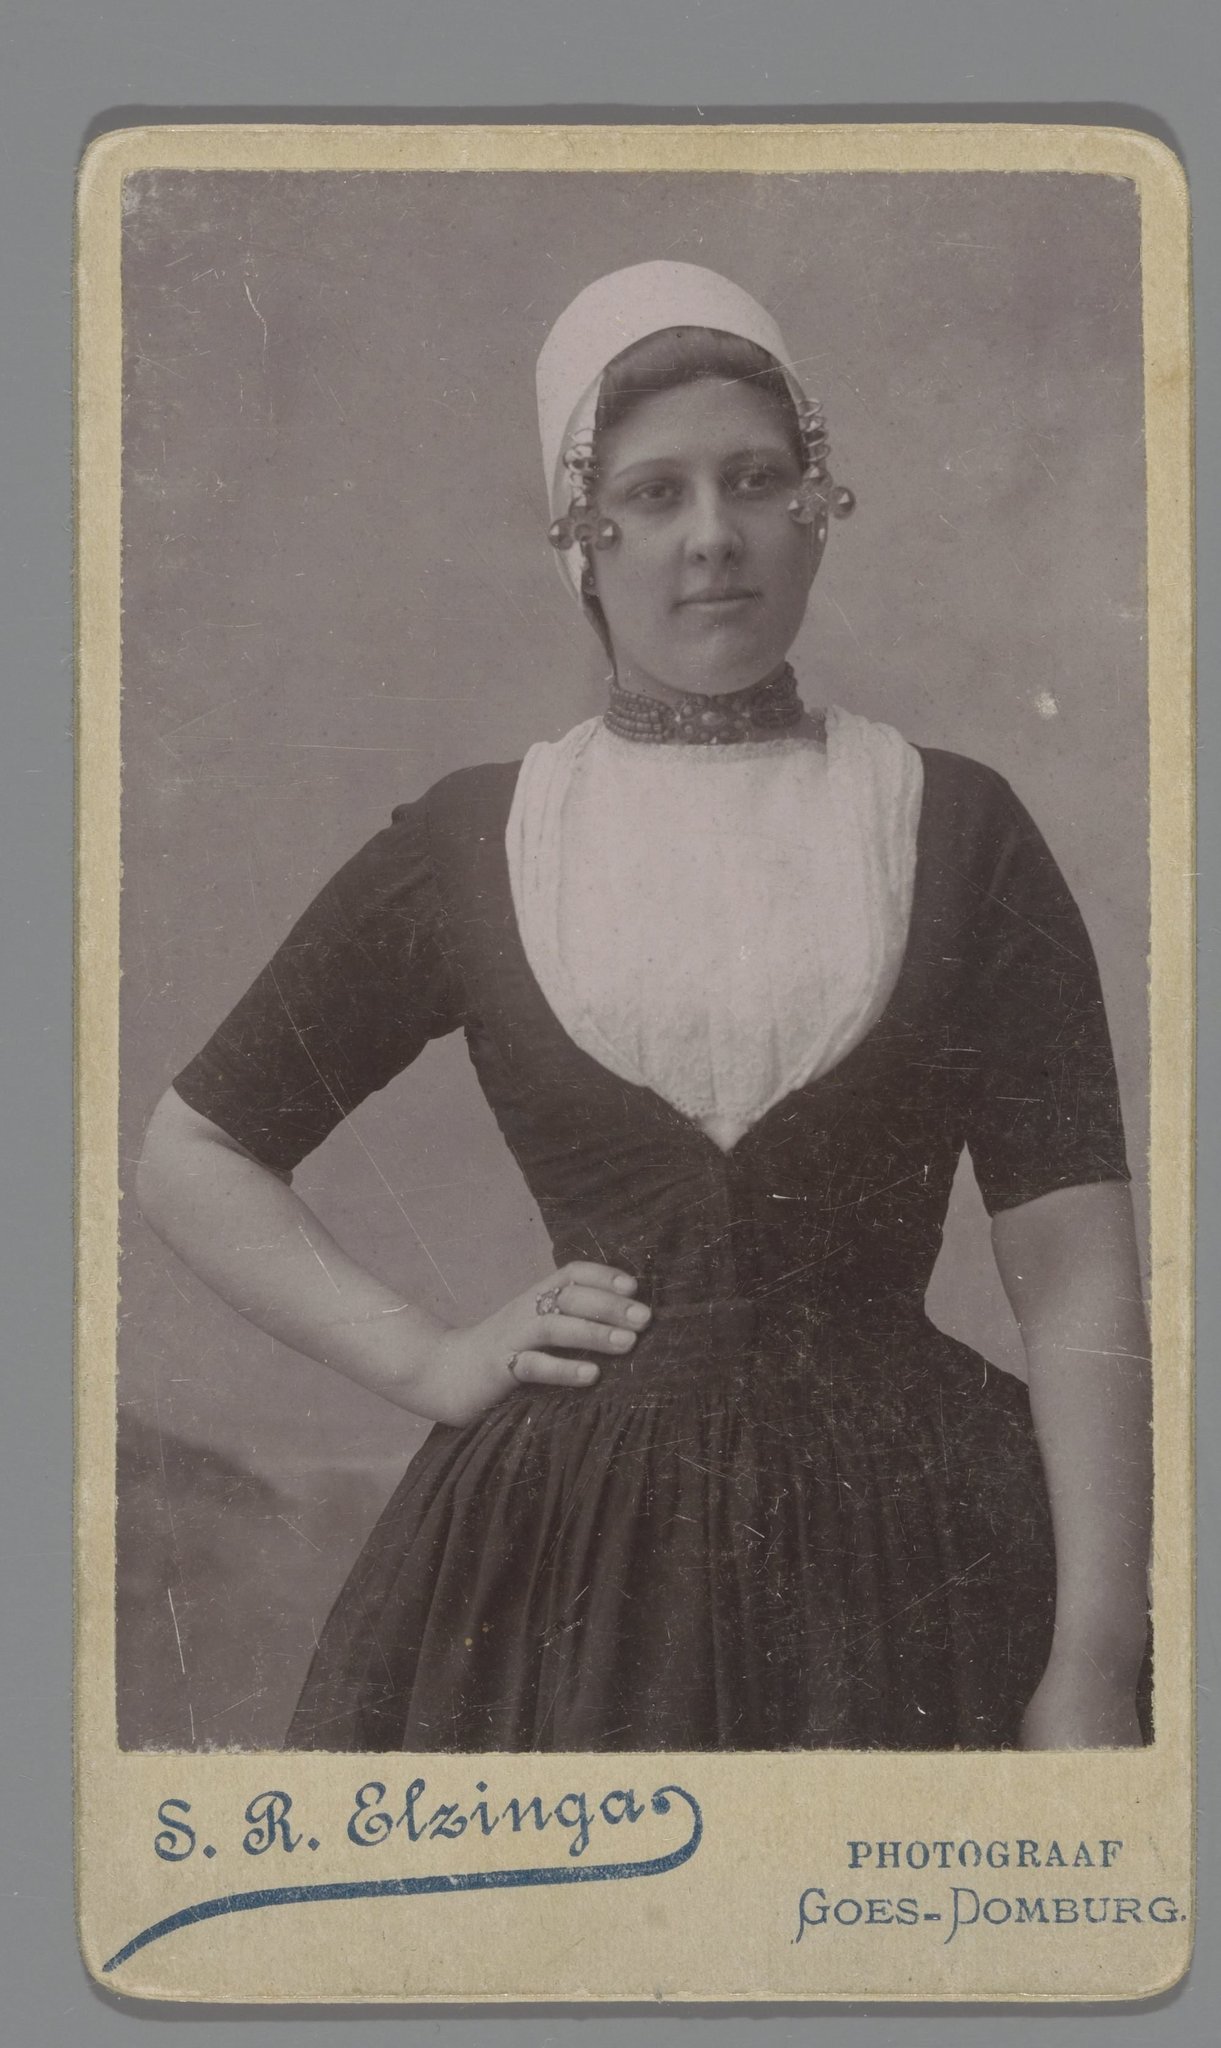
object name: photograph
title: Portret van een onbekende jonge vrouw in Zeeuwse klederdracht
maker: sytze reinder elzinga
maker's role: fotograaf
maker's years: 1858-1912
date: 1900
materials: paper, cardboard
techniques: collodion silver print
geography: domburg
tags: adolescent, young woman, maiden, anonymous historical person portrayed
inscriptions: inscription: ‘S.R. Elzinga/ Photograaf/ Goes-Domburg.’, inscription: ‘Ple[...]tf./ 1900’